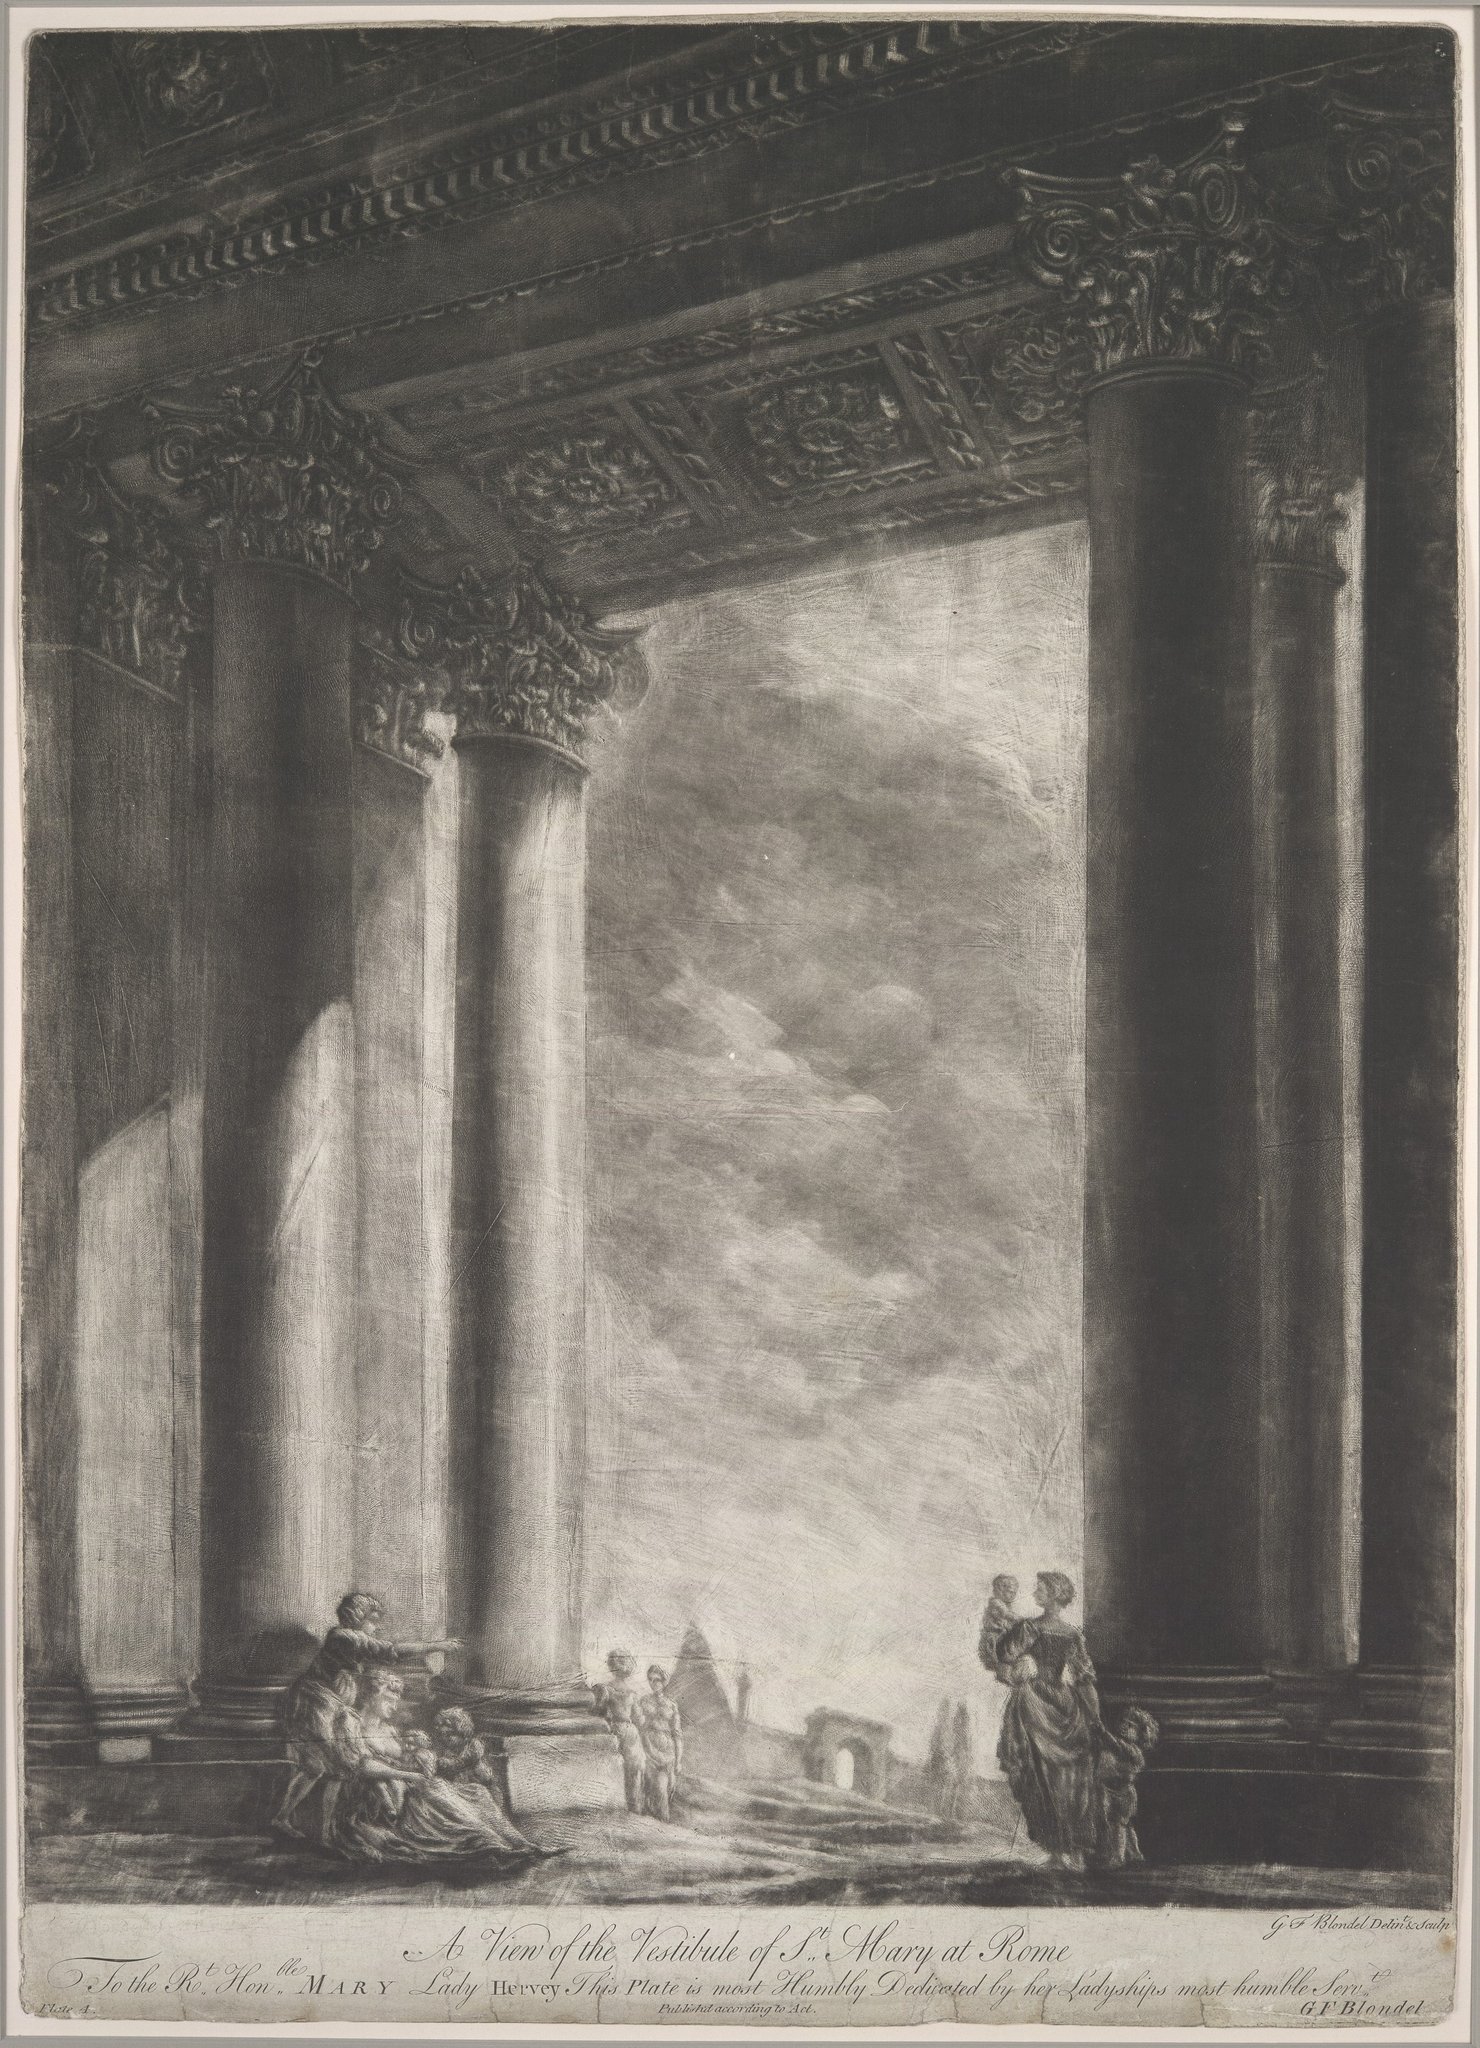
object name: print ornament architecture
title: A View of the Vestibule of Santa Maria Maggiore at Rome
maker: georges françois blondel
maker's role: artist and publisher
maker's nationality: french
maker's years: 1730-1792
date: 1765-1767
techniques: mezzotint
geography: london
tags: columns,infants,men,women